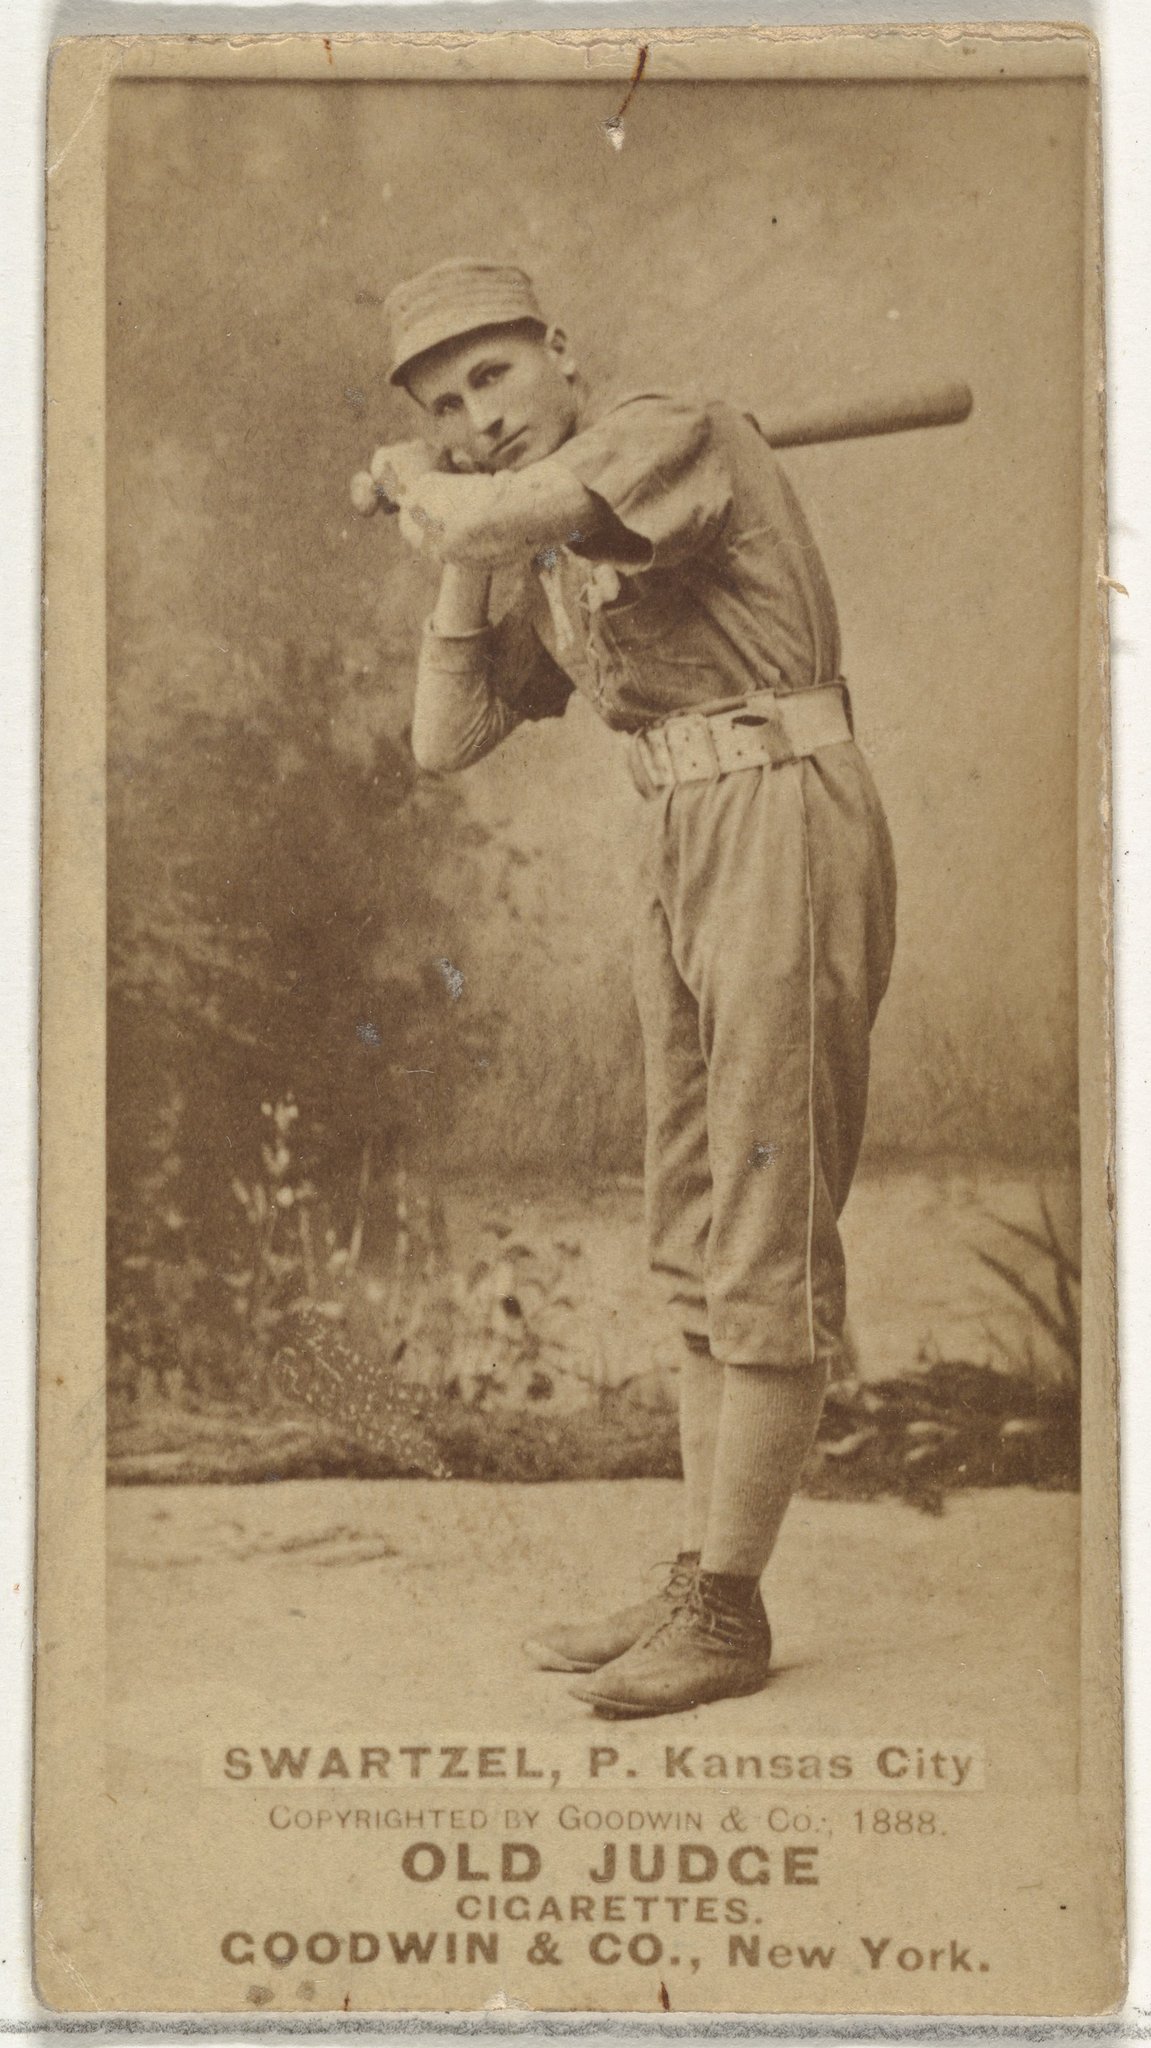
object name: baseball card, photograph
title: Parke B. Swartzel, Pitcher, Kansas City Cowboys, from the Old Judge series (N172) for Old Judge Cigarettes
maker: goodwin & company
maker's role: publisher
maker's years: 1850-1950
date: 1888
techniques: albumen silver print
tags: men,portraits,baseball,athletes